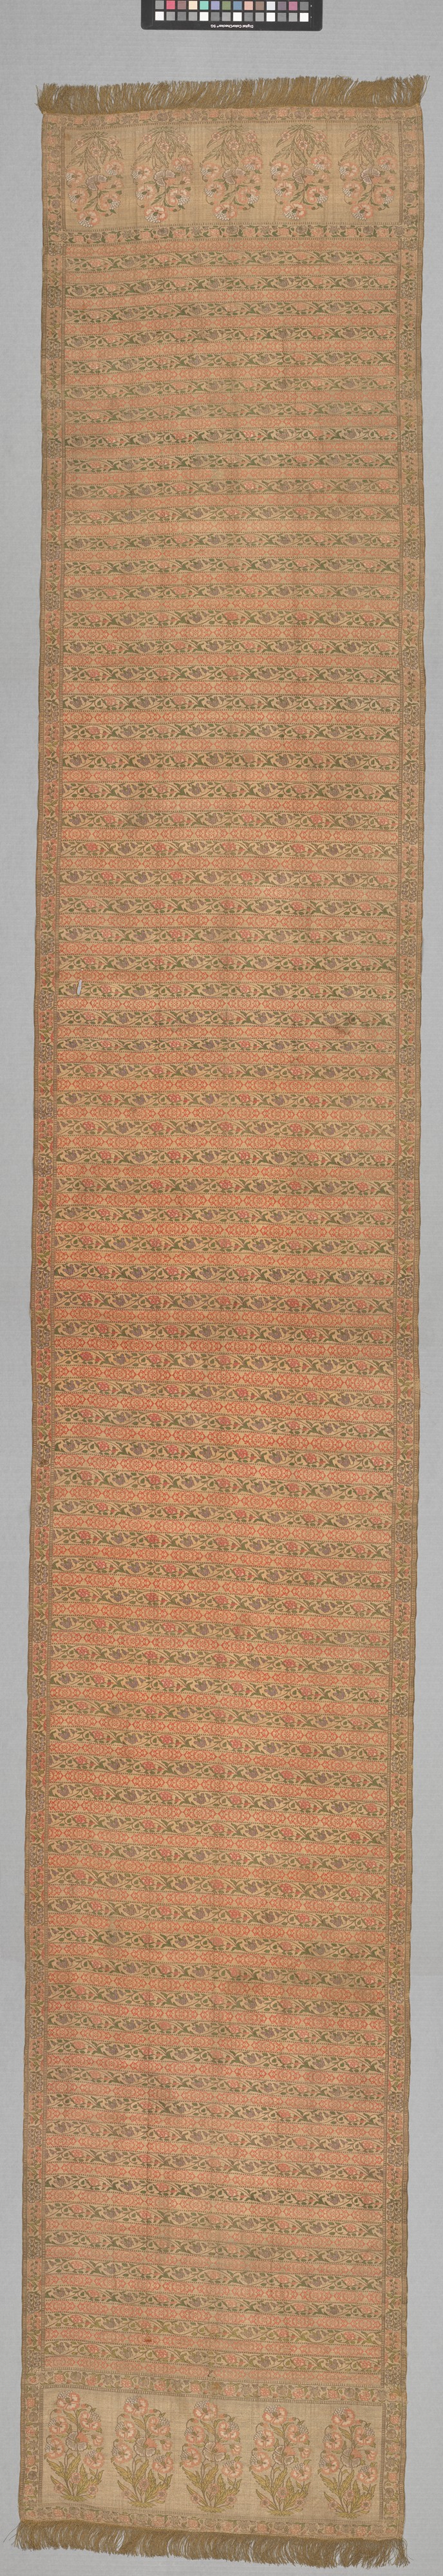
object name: sash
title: Sash with Flowering Plants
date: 1601-1700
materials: metal thread, silk, silver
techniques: brocade, gilding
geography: iran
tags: flowers